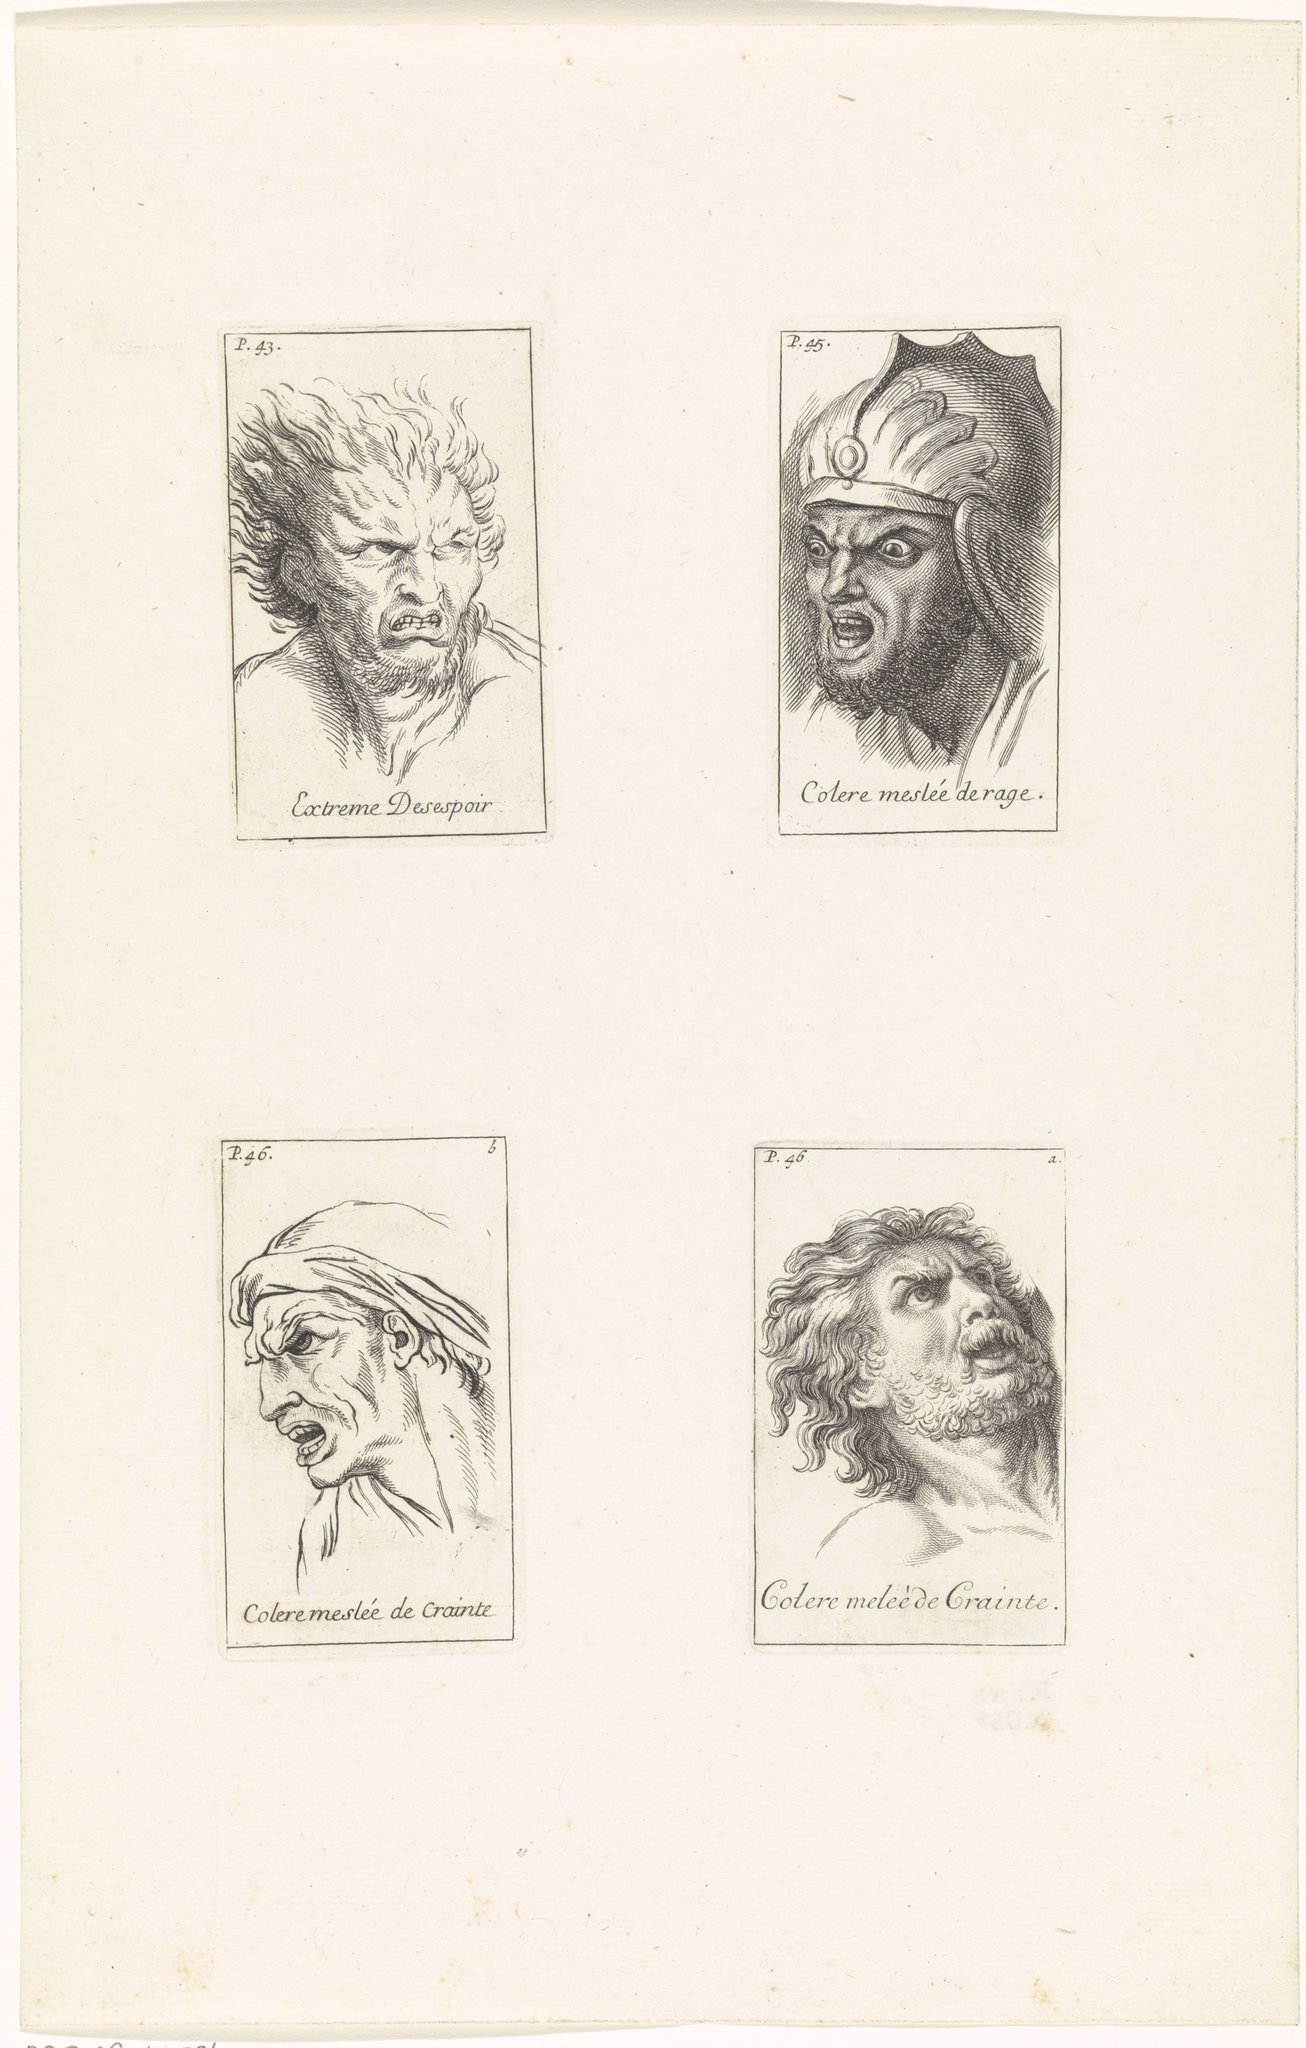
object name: book illustration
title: Voorstellingen van verschillende emoties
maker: bernard picart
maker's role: draughtsman, print maker, publisher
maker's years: 1673-1733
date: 1711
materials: paper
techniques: engraving, etching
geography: amsterdam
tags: morphology of facial expression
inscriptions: collector's mark: Lugt 2165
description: Onversneden blad met vier prenten met voorstellingen van mannenkoppen die verschillende emoties uitdrukken. Van links naar rechts, van boven naar beneden: Extreme Desespoir, Colere meslée de rage, Colere meslée de Crainte, Colere meleè de Crainte. De prenten hebben een titel in het Frans en zijn gemerkt met een paginanummer en een letter.